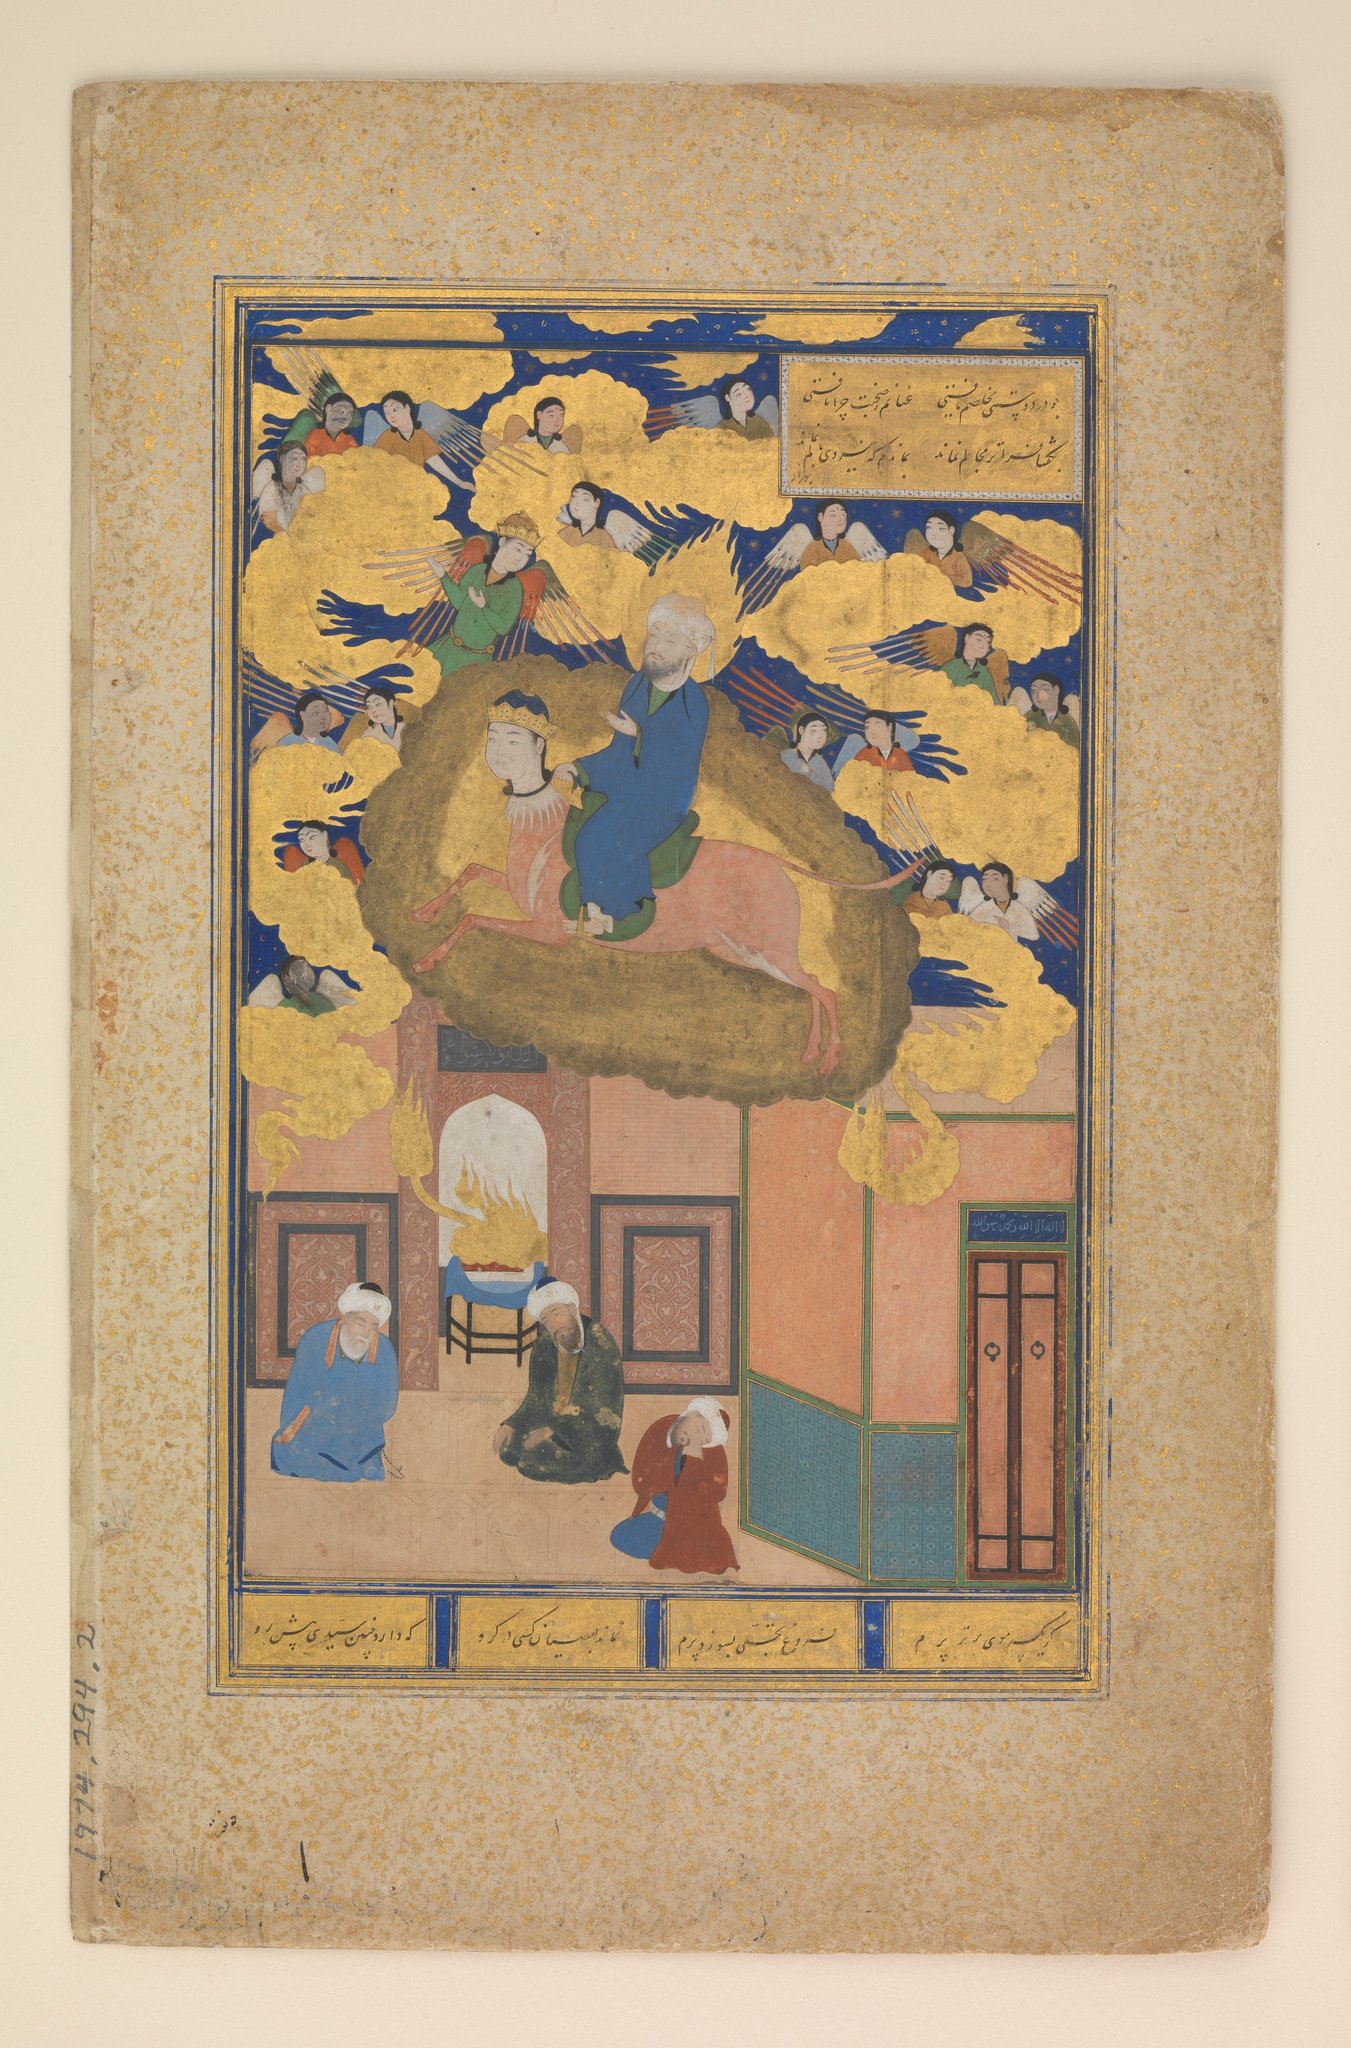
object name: folio from an illustrated manuscript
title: "The Mi'raj or The Night Flight of Muhammad on his Steed Buraq", Folio 3v from a Bustan of Sa`di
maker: sultan muhammad nur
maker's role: calligrapher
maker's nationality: iranian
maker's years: 1448-1561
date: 1525-1535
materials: gold, ink, paper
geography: uzbekistan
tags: men,mythical creatures